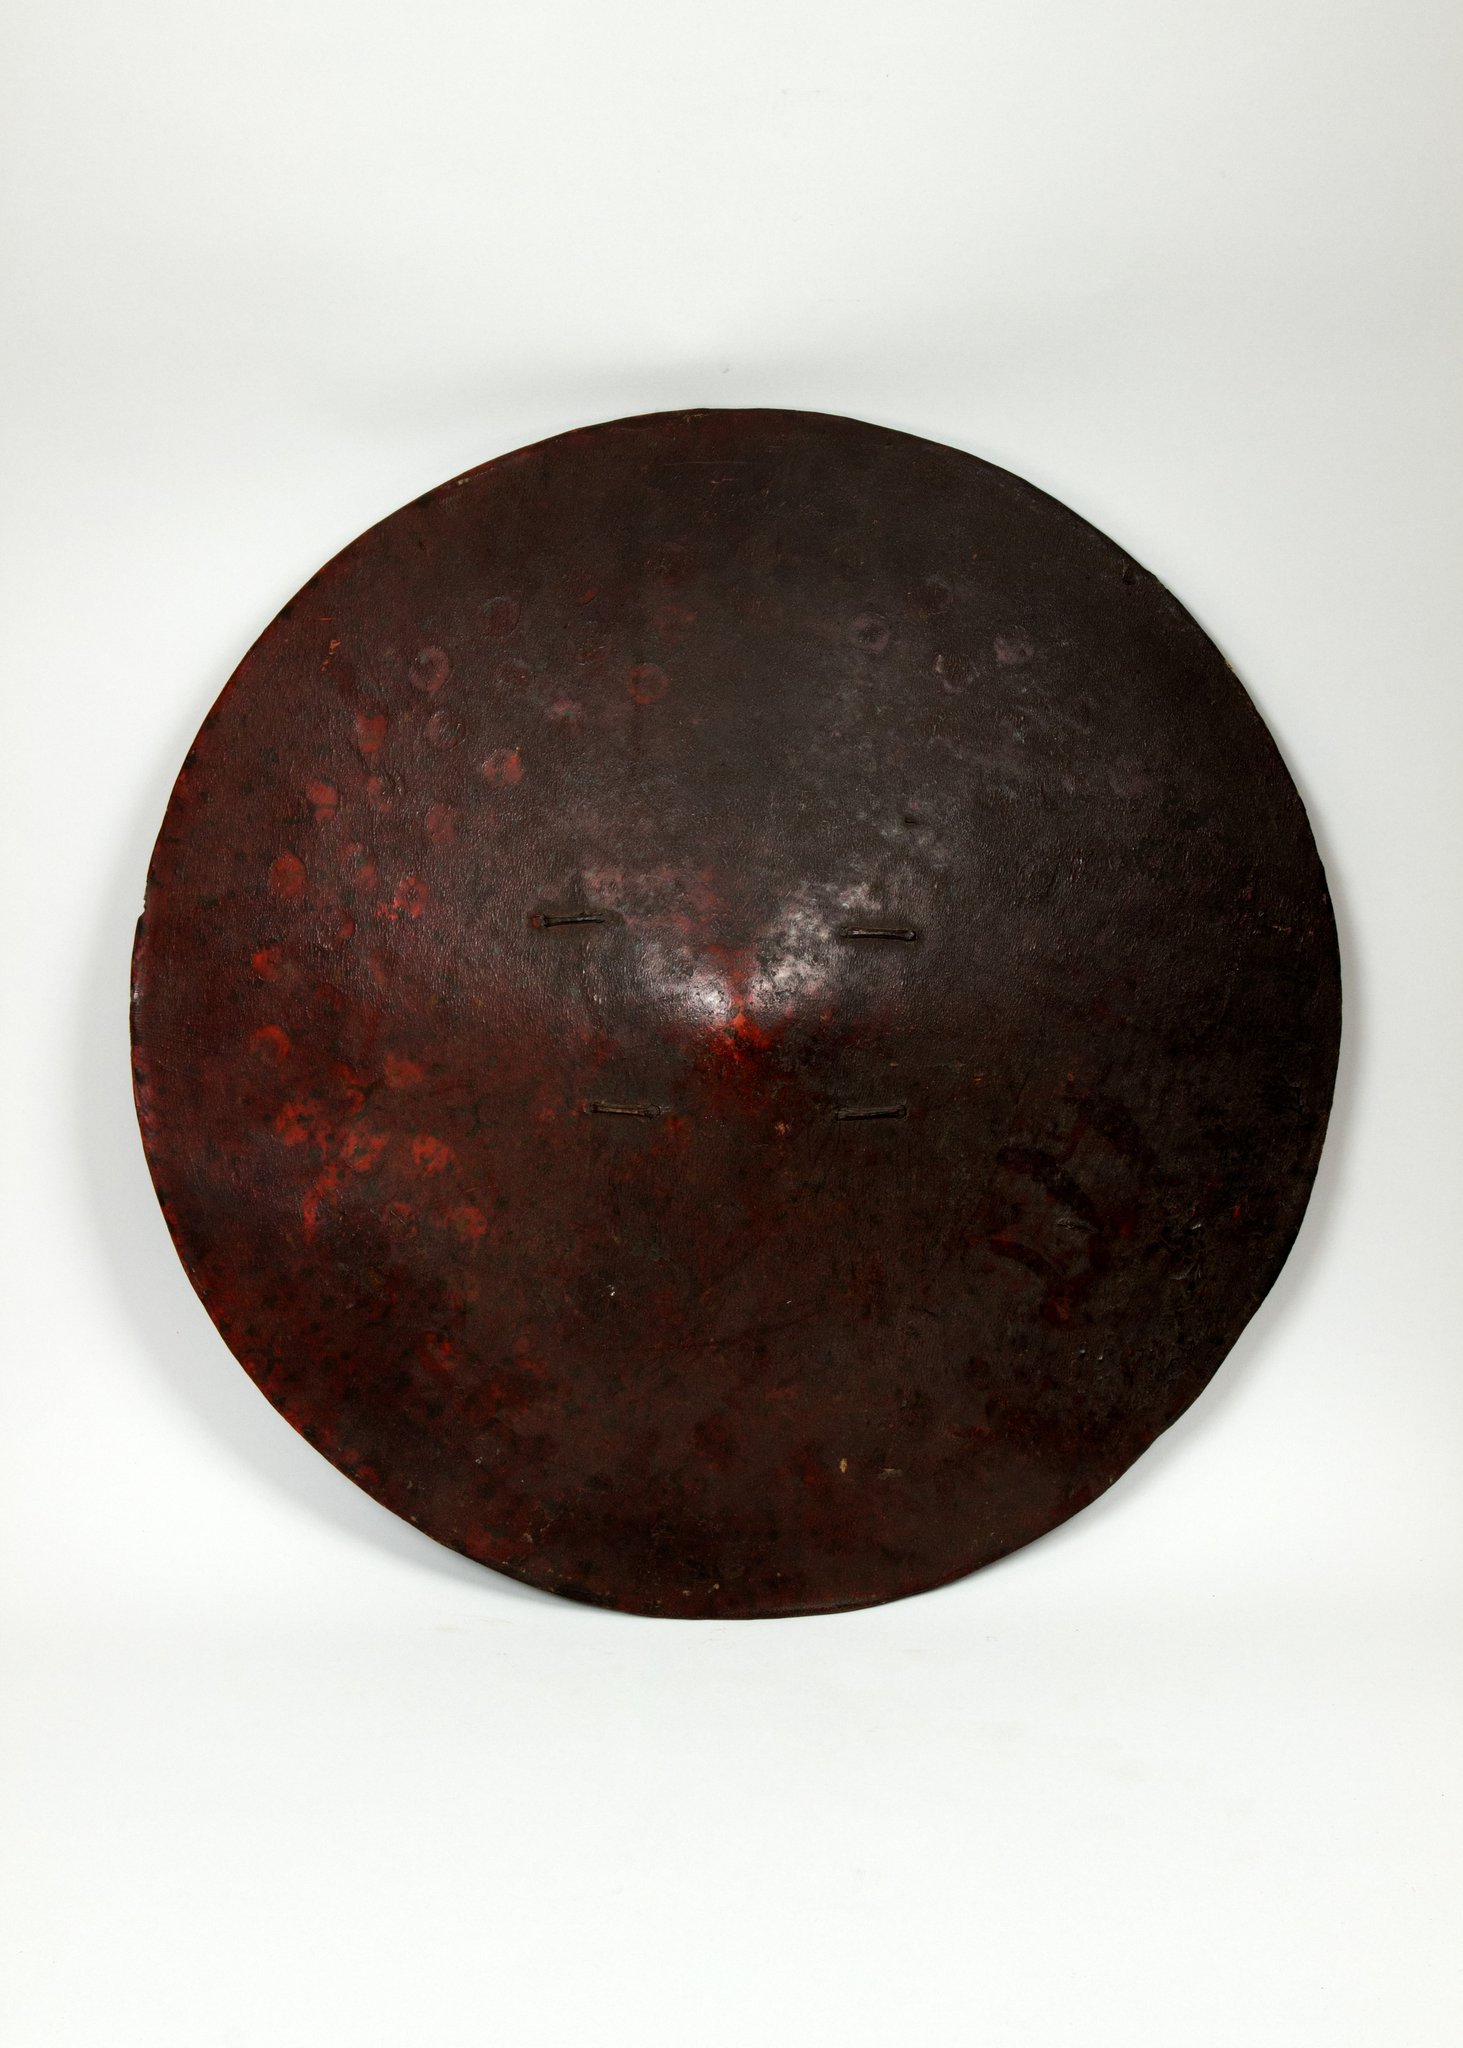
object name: shield dhàl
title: Shield (Dhàl)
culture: indian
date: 1801-1900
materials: leather, textile, wood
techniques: polychromy